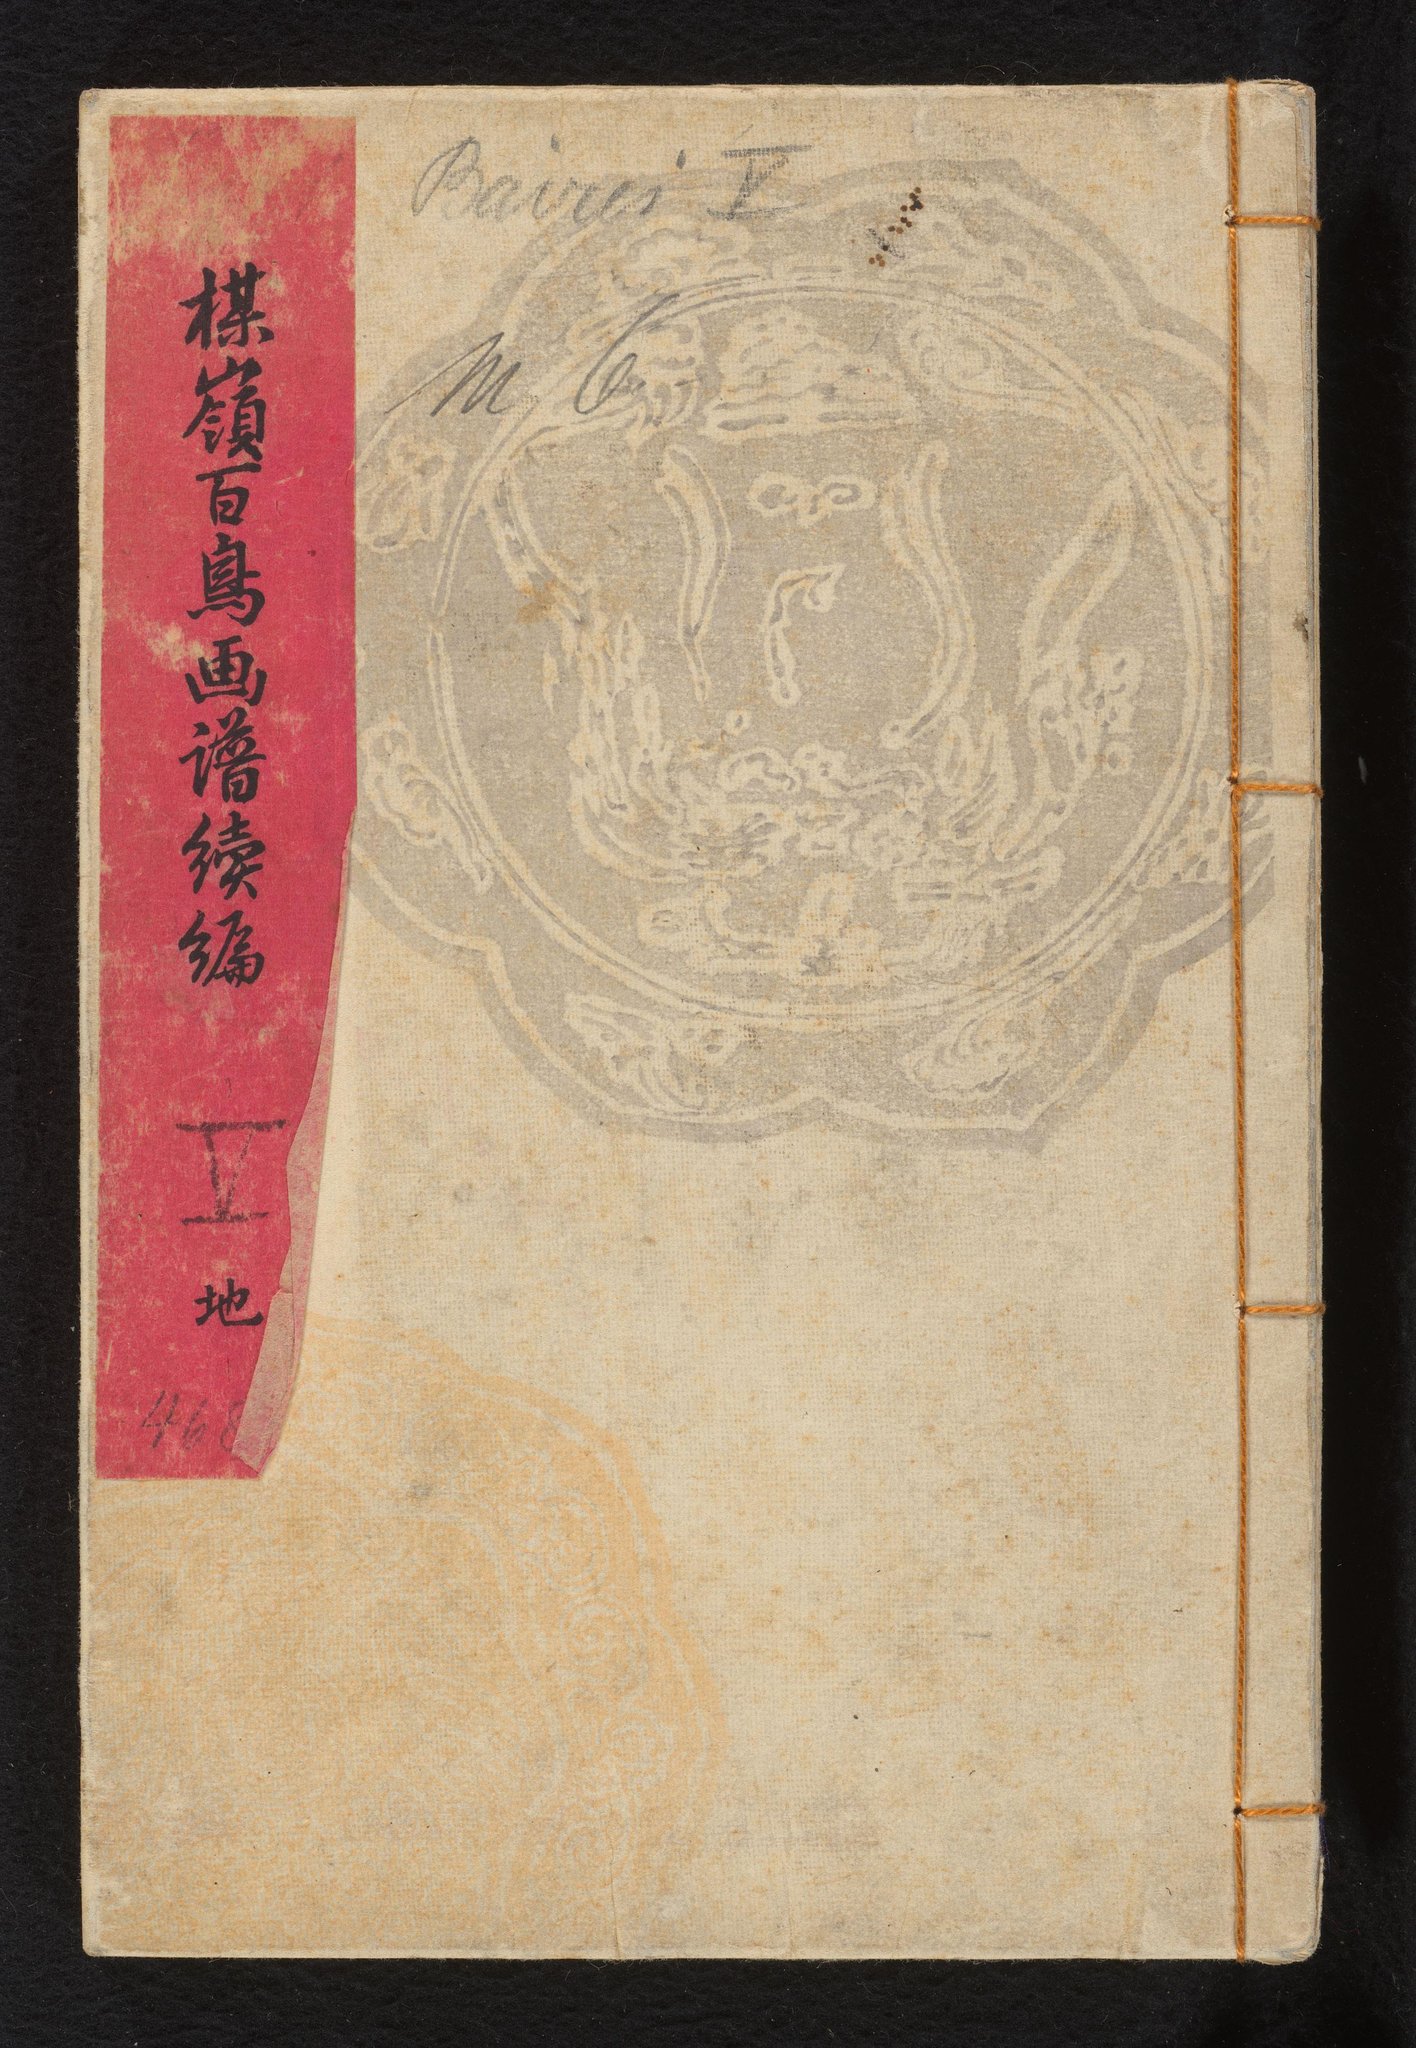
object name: book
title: Album met honderd vogels door Bairei - deel drie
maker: kôno bairei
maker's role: painter, print maker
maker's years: 1844-1895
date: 1884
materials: paper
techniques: woodcut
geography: japan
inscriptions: number: ‘1459 No. 1’, inscription: ‘Bairei’